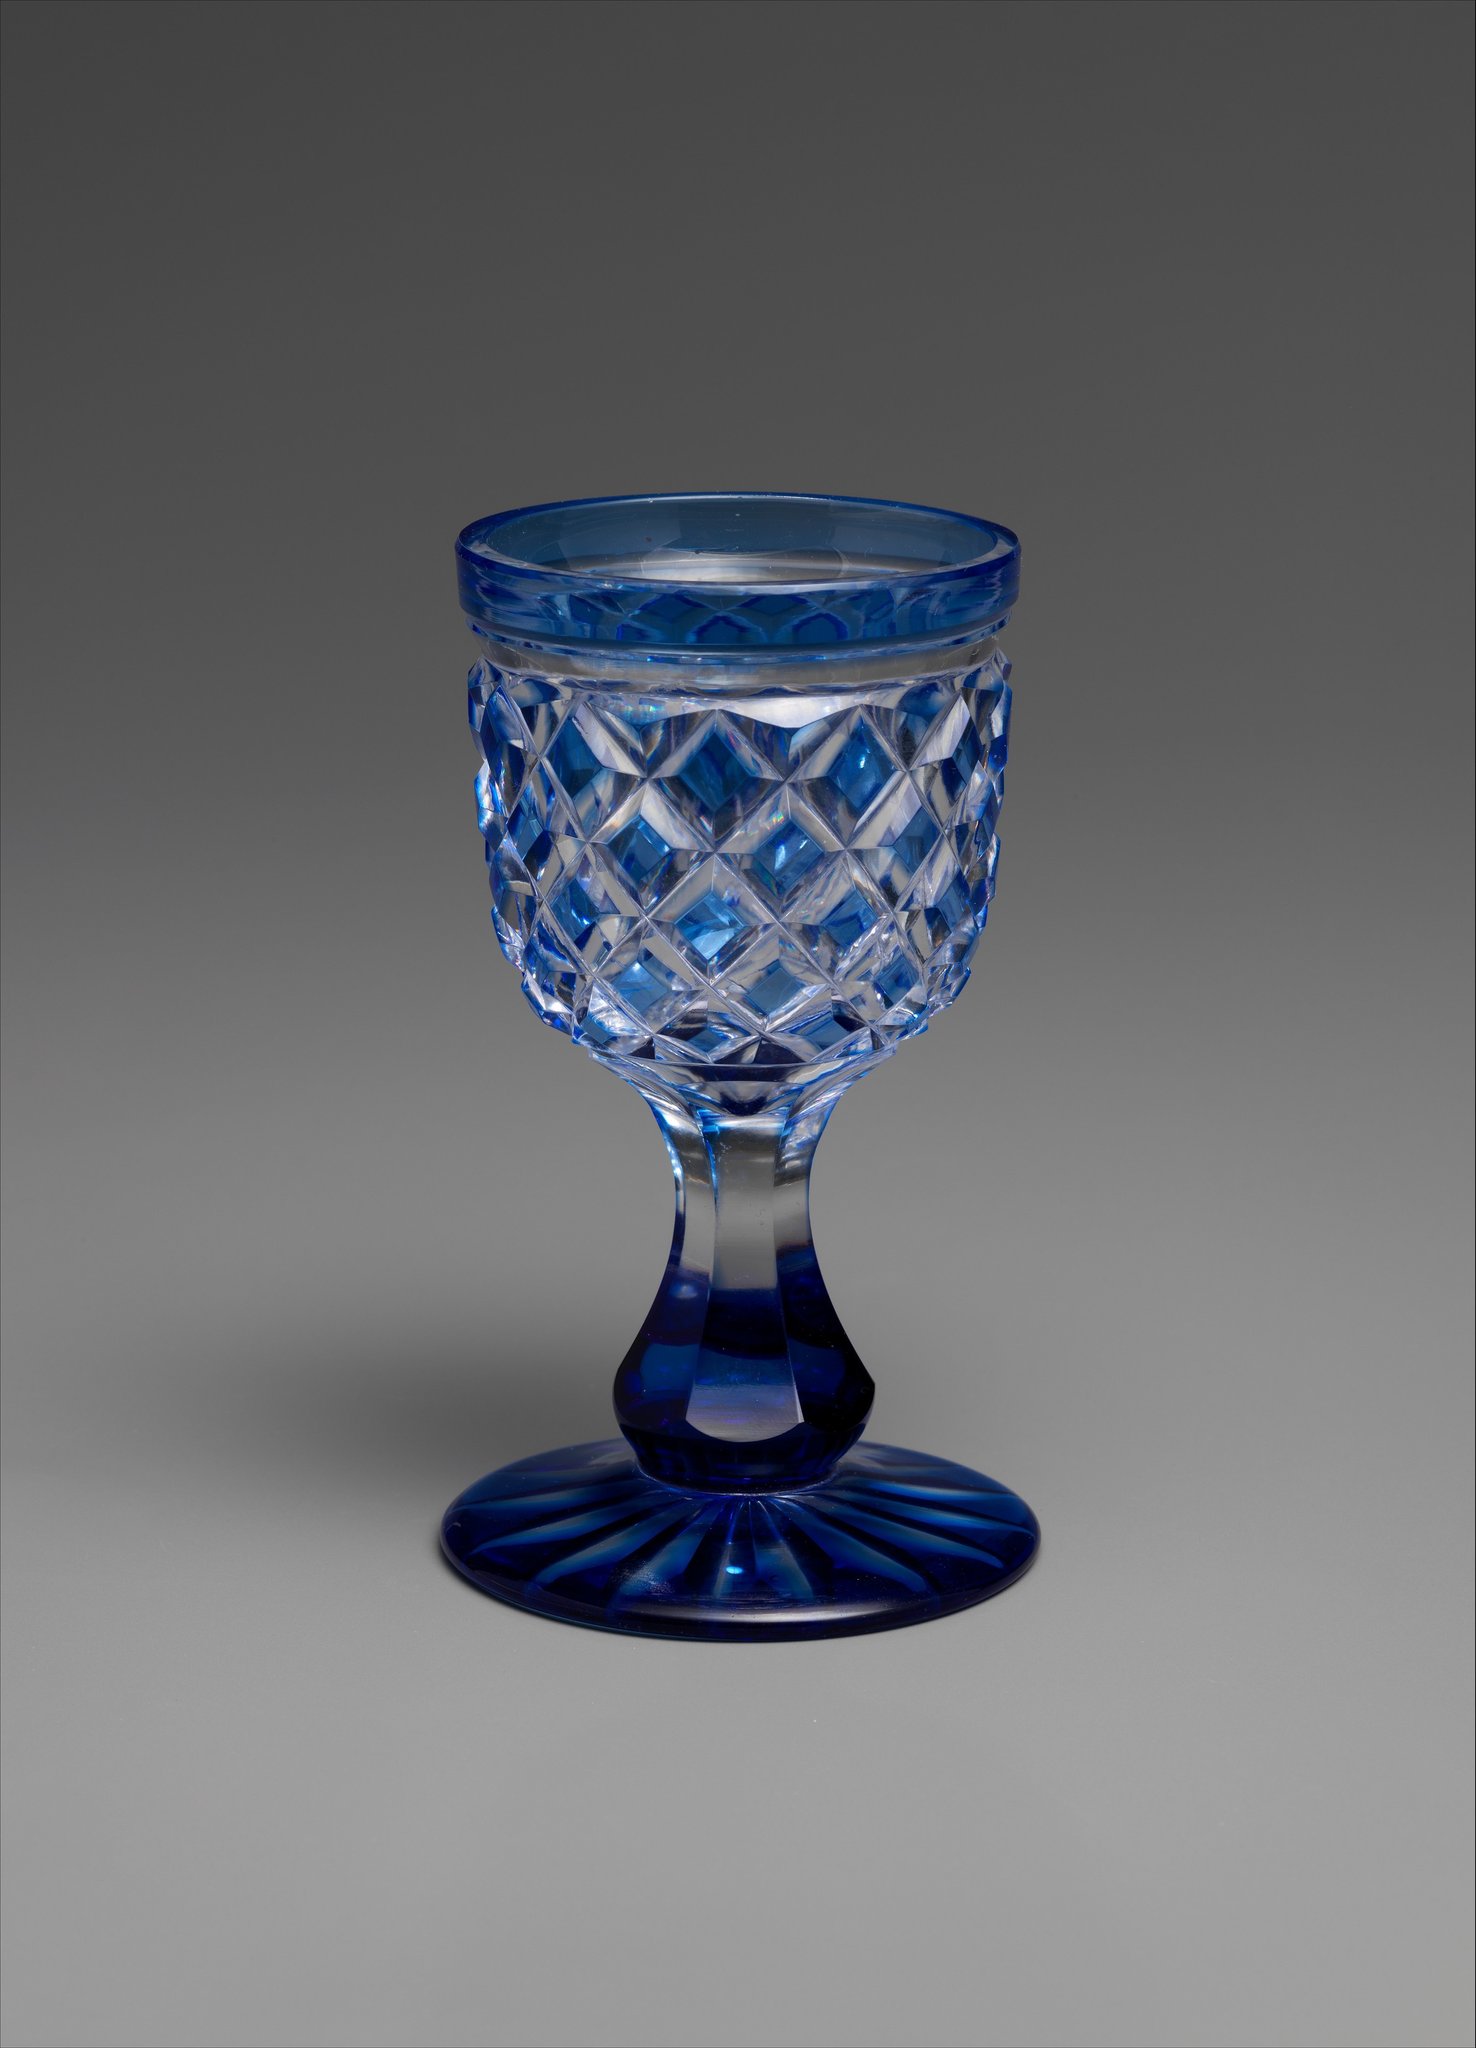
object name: cordial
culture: american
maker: brooklyn flint glass company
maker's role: manufacturer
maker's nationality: american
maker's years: 1824-1868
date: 1850-1855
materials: glass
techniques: cutting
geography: united states